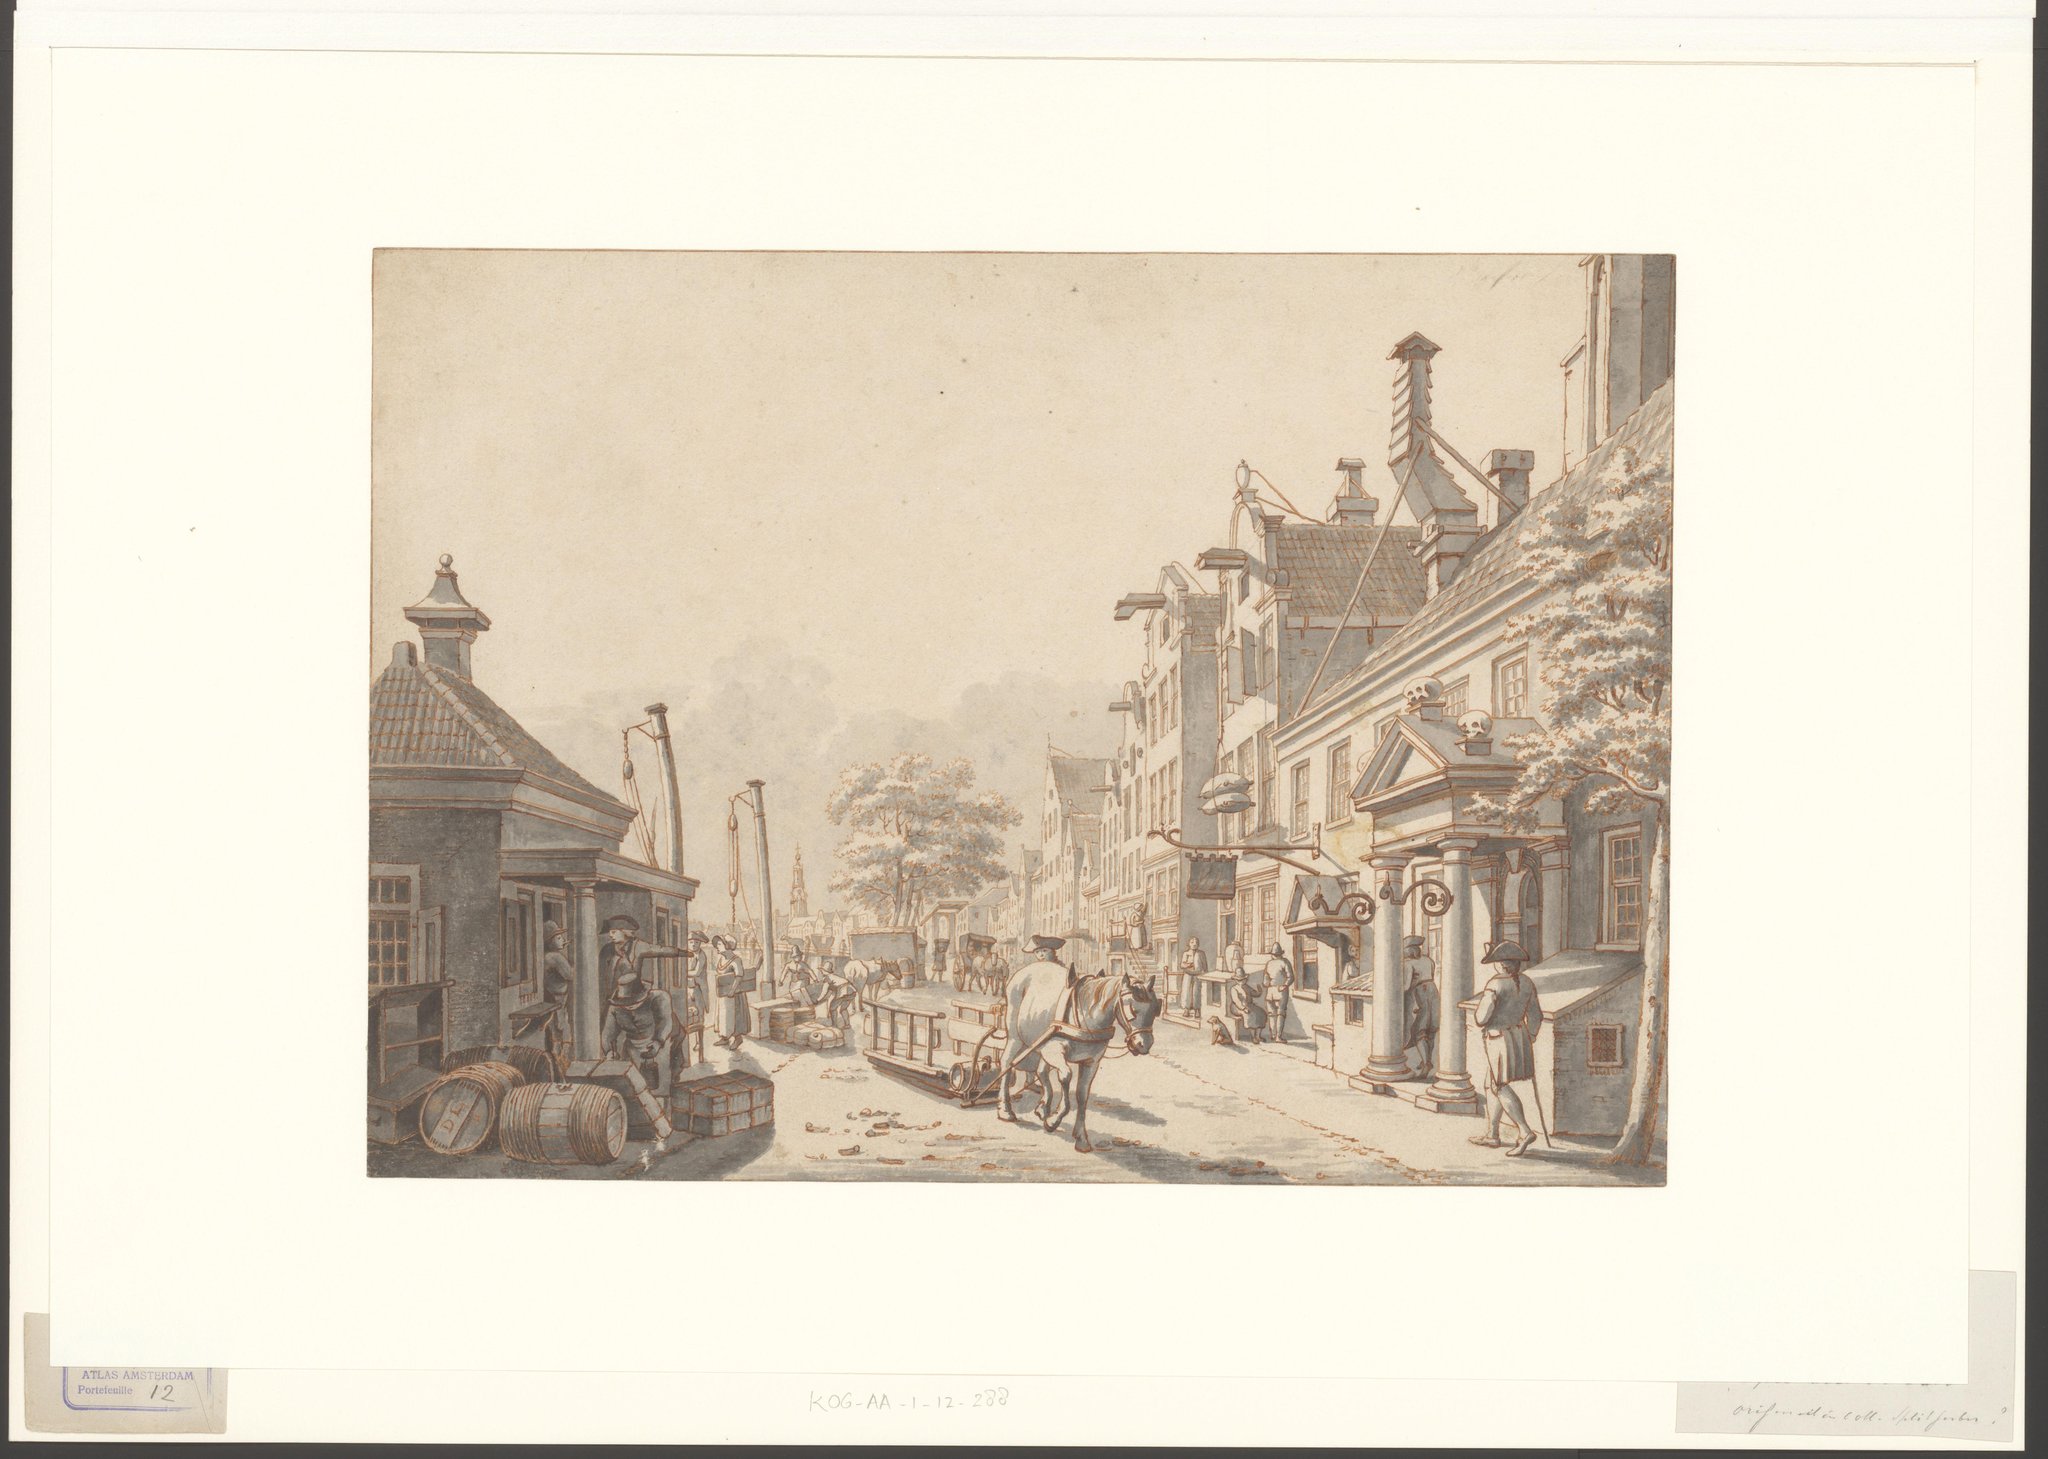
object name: drawing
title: Gezicht op de ingang van de Nieuwezijds Kapel aan het Rokin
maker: Anonymous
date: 1800-1850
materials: ink, paper, pencil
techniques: brush, pen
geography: amsterdam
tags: horse-sleigh, city-view in general; 'veduta', street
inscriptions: inscription: ‘Port. 12 - 288’, inscription: ‘Auctie Boos / 1880. / Copie naar J. Cats / origineel in coll. Splitgerber ?’, collector's mark: ‘12’ Lugt 1641b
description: Onderwerpsrubriek binnen de Atlas Amsterdam: Rokin, Rotterdammersloot, Rozengang, Rozengracht, Rozenstraat, Rusland, Rustenburgerstraat, Ruysdaelkade, Ruysdaelstraat, Ruyterkade (de), Ruyterweg (Admiraal de).